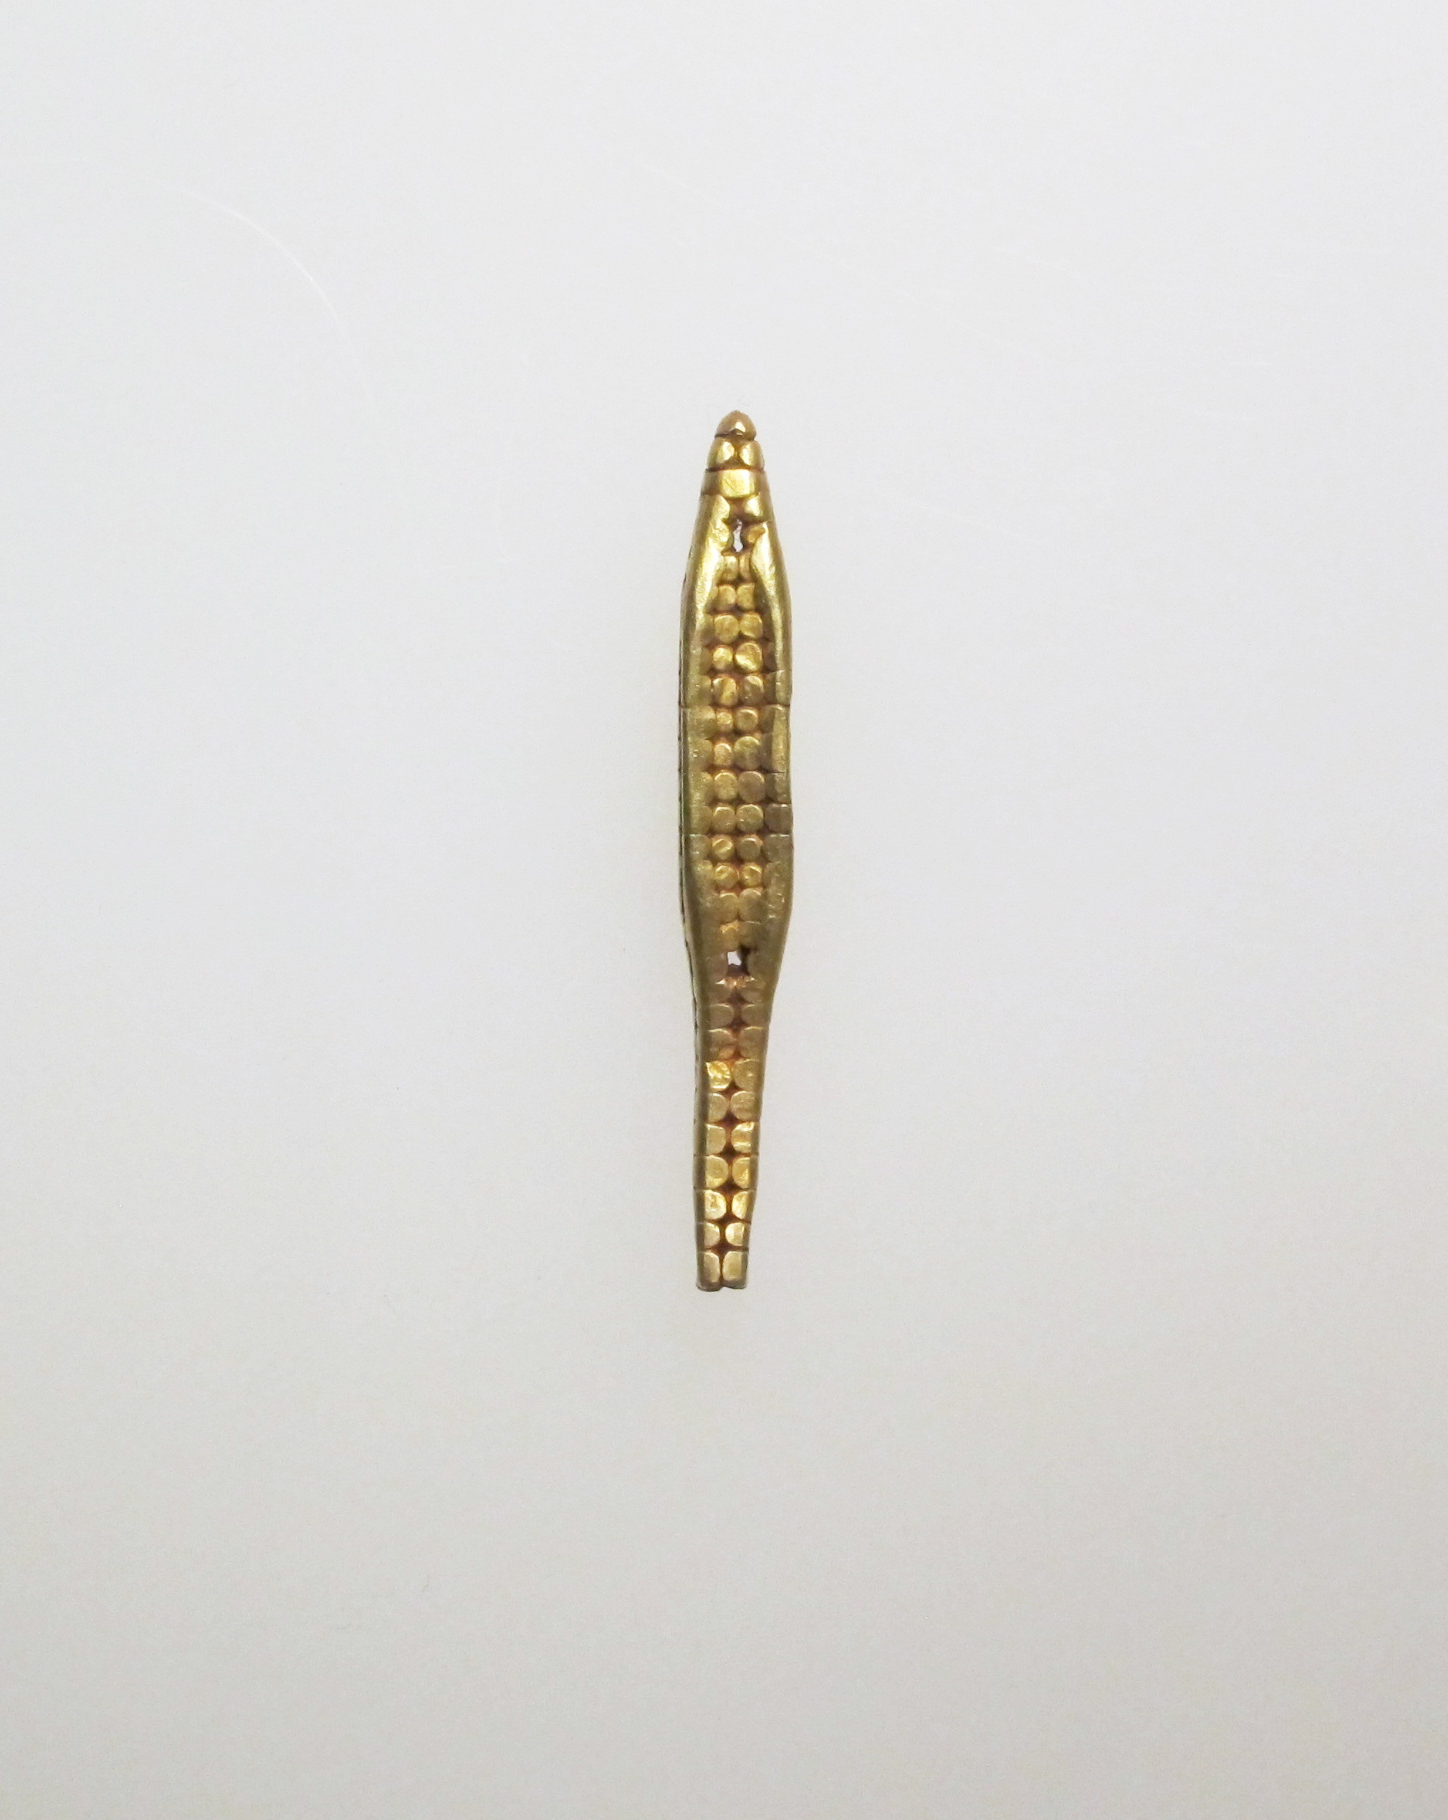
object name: pendant in the form of a lance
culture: greek or roman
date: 7000 BCE-330 CE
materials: gold